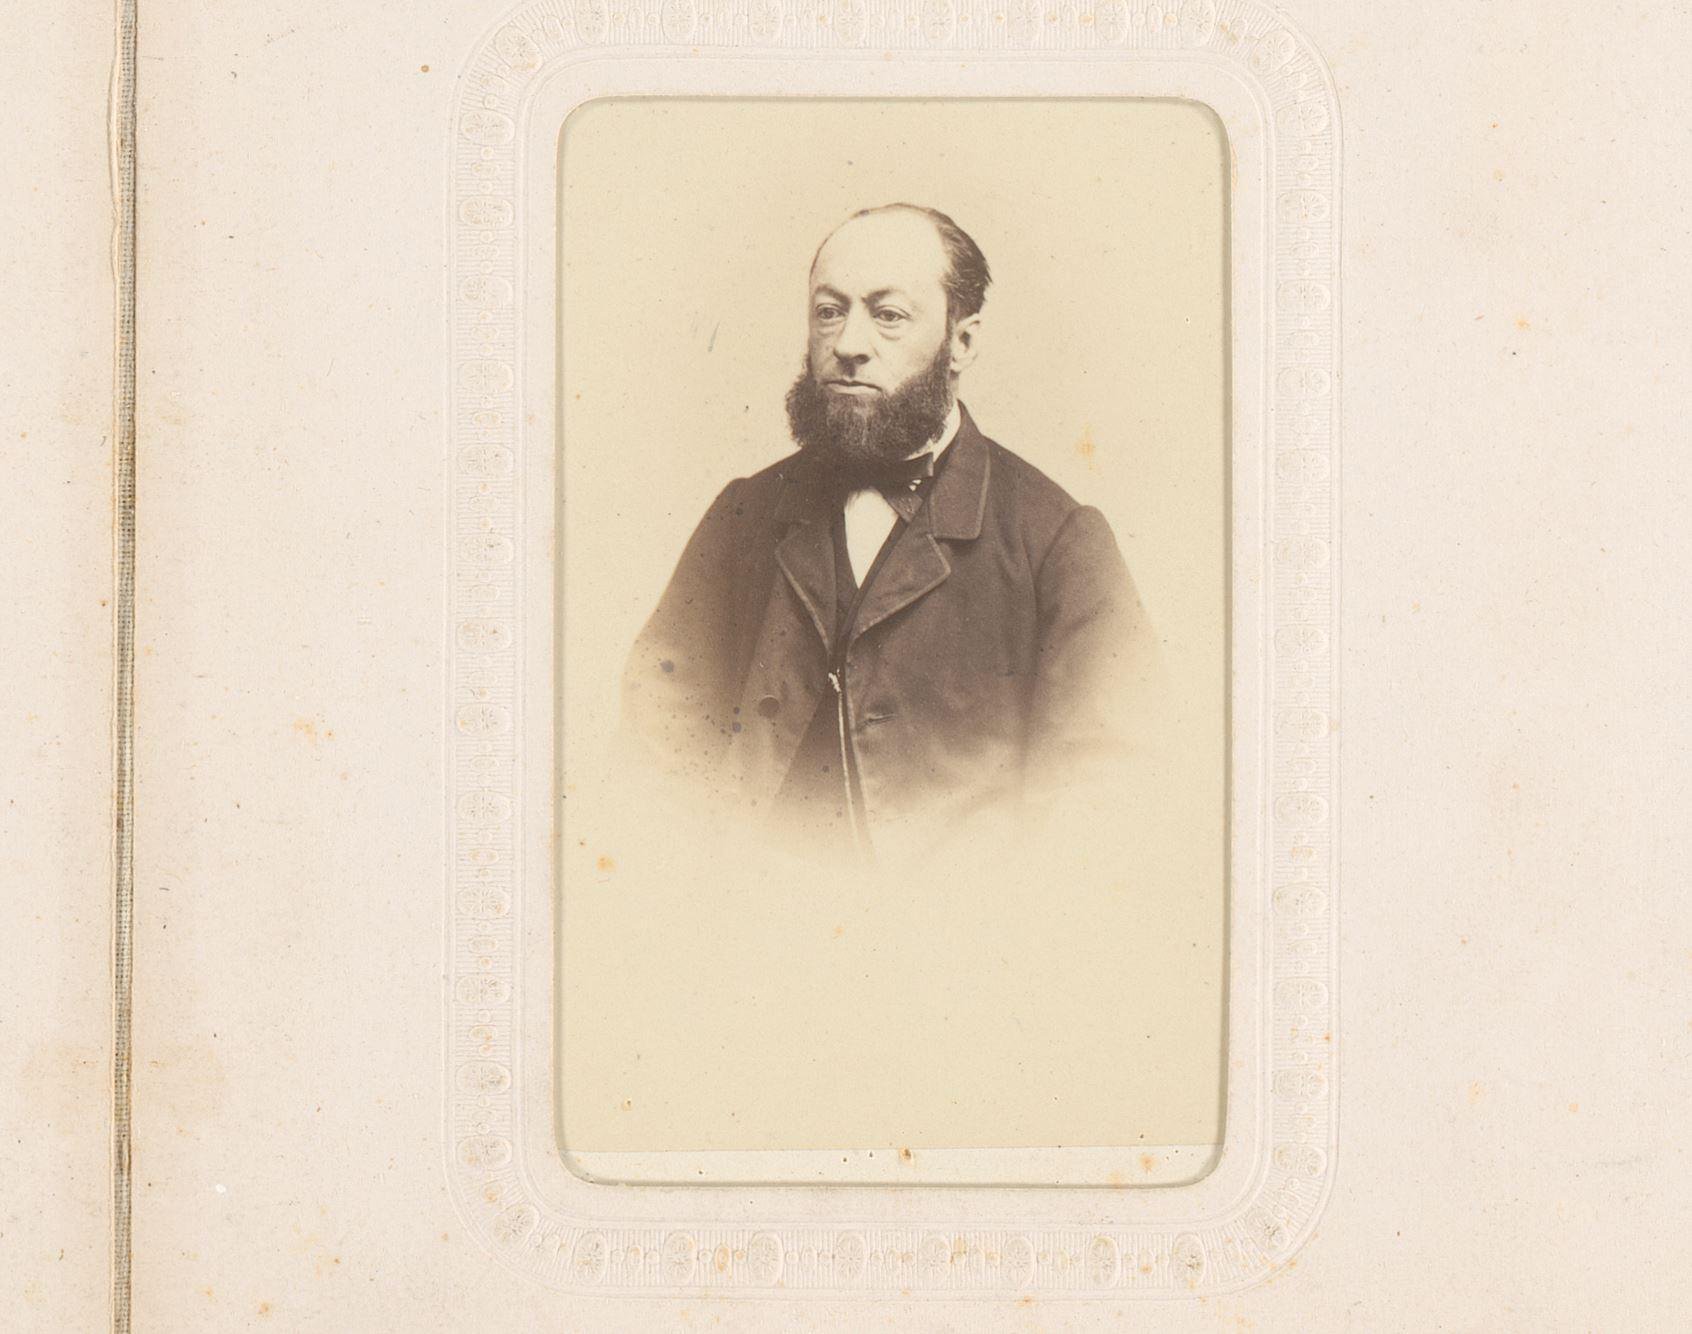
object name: photograph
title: Portret van een man met baard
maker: Anonymous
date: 1860-1900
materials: cardboard, photographic support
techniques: albumen print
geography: netherlands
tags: historical persons, beard